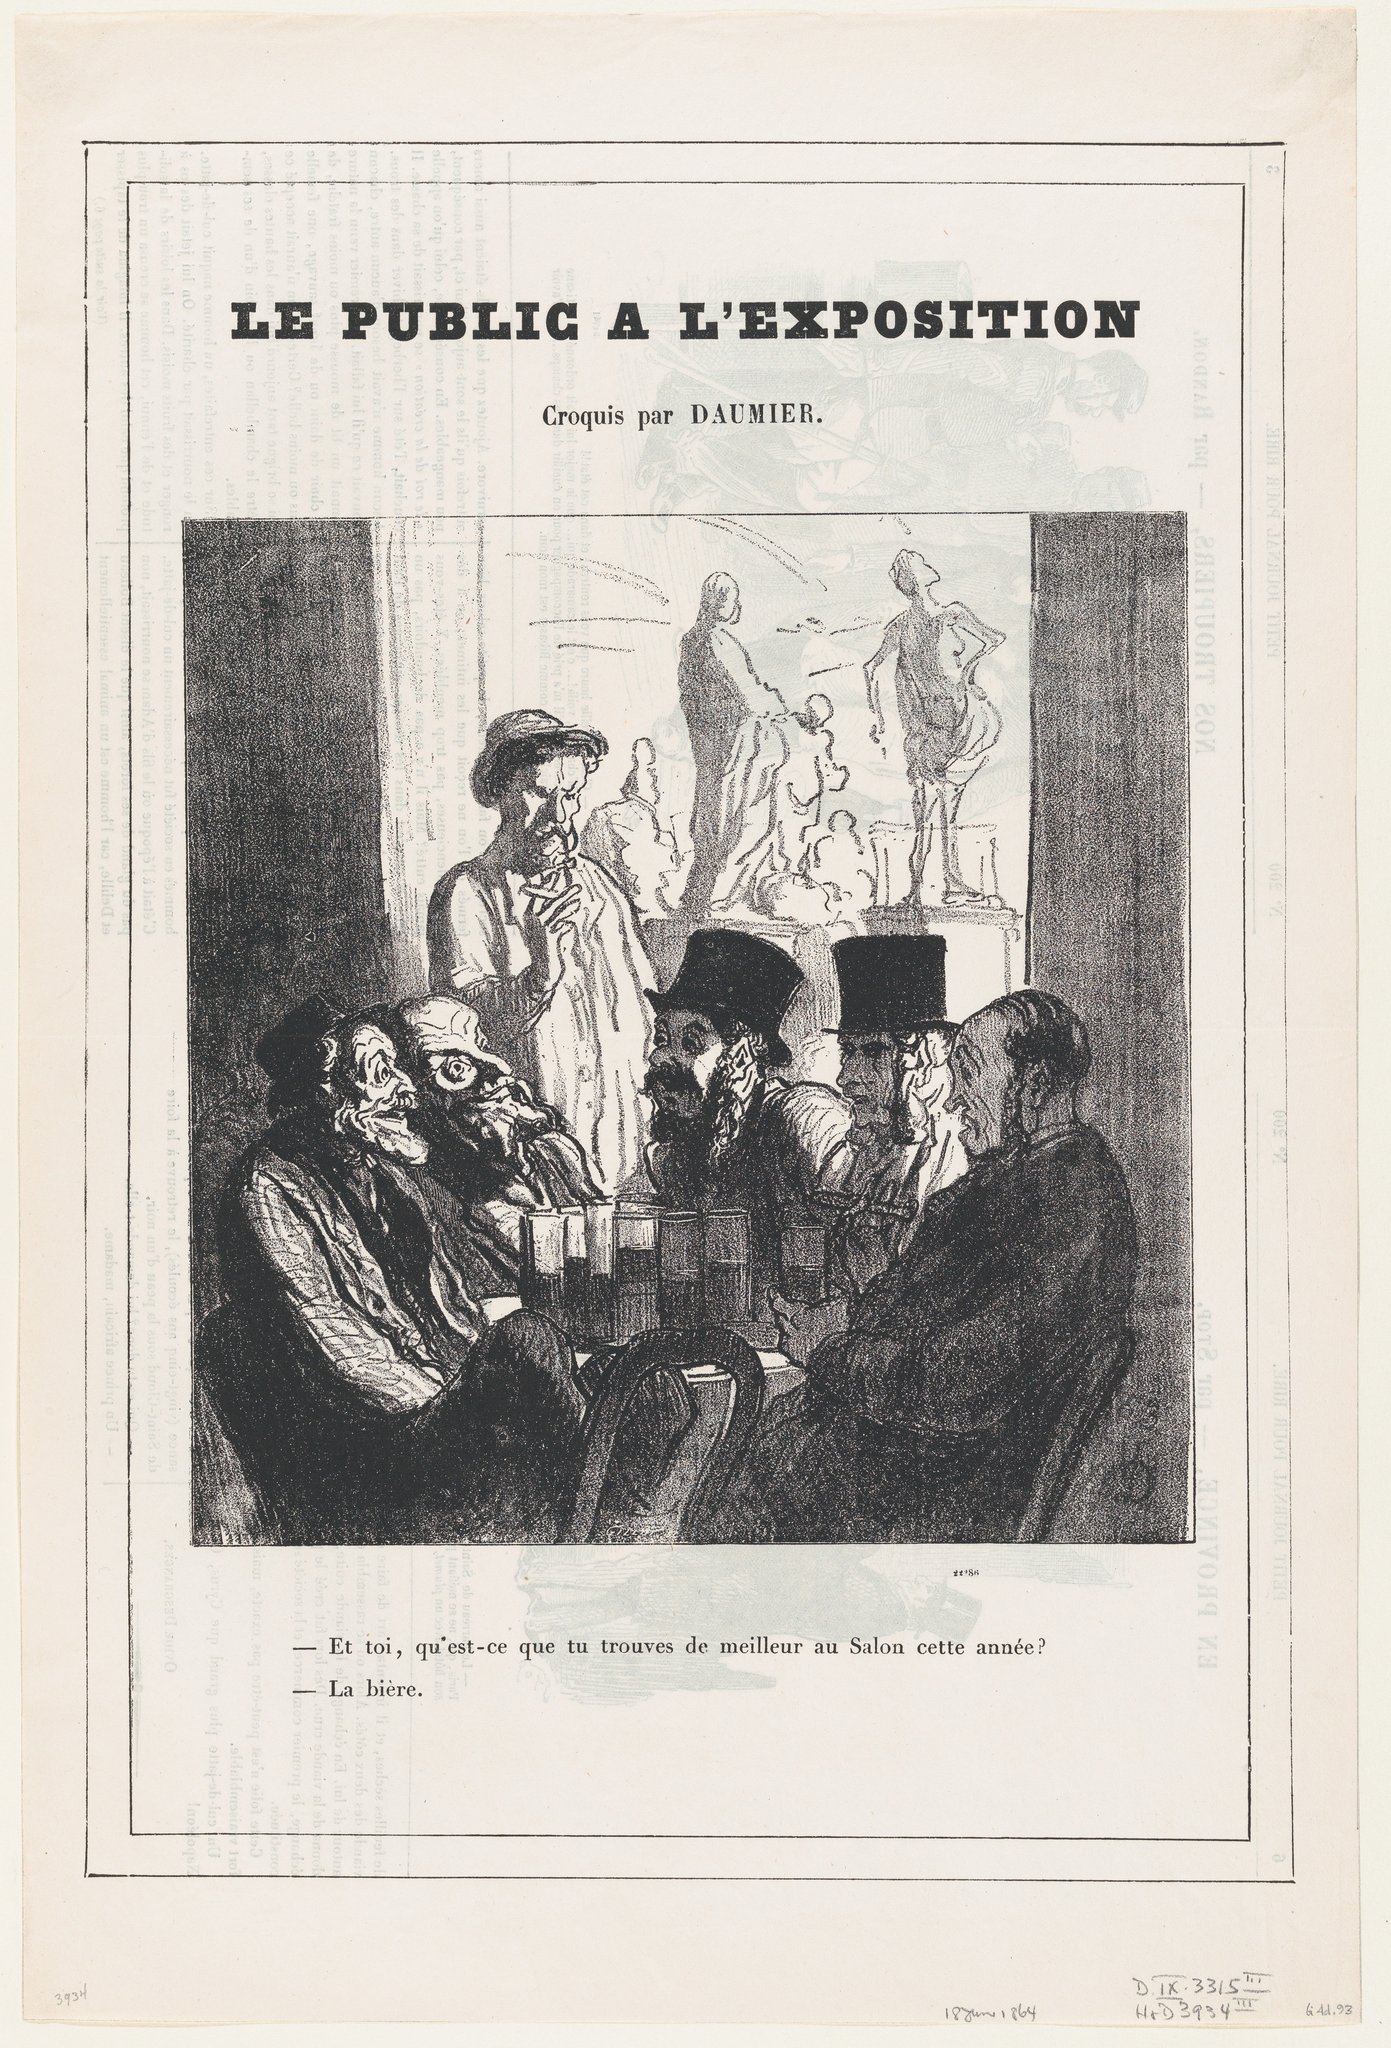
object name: print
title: And you, what do you like best at this year's Salon? The beer!, from 'The public at the exhibition,' published in Le Petit Journal pour Rire, June 18, 1864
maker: honoré daumier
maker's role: artist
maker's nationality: french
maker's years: 1808-1879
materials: paper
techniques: lithograph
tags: men,smoking,drinking